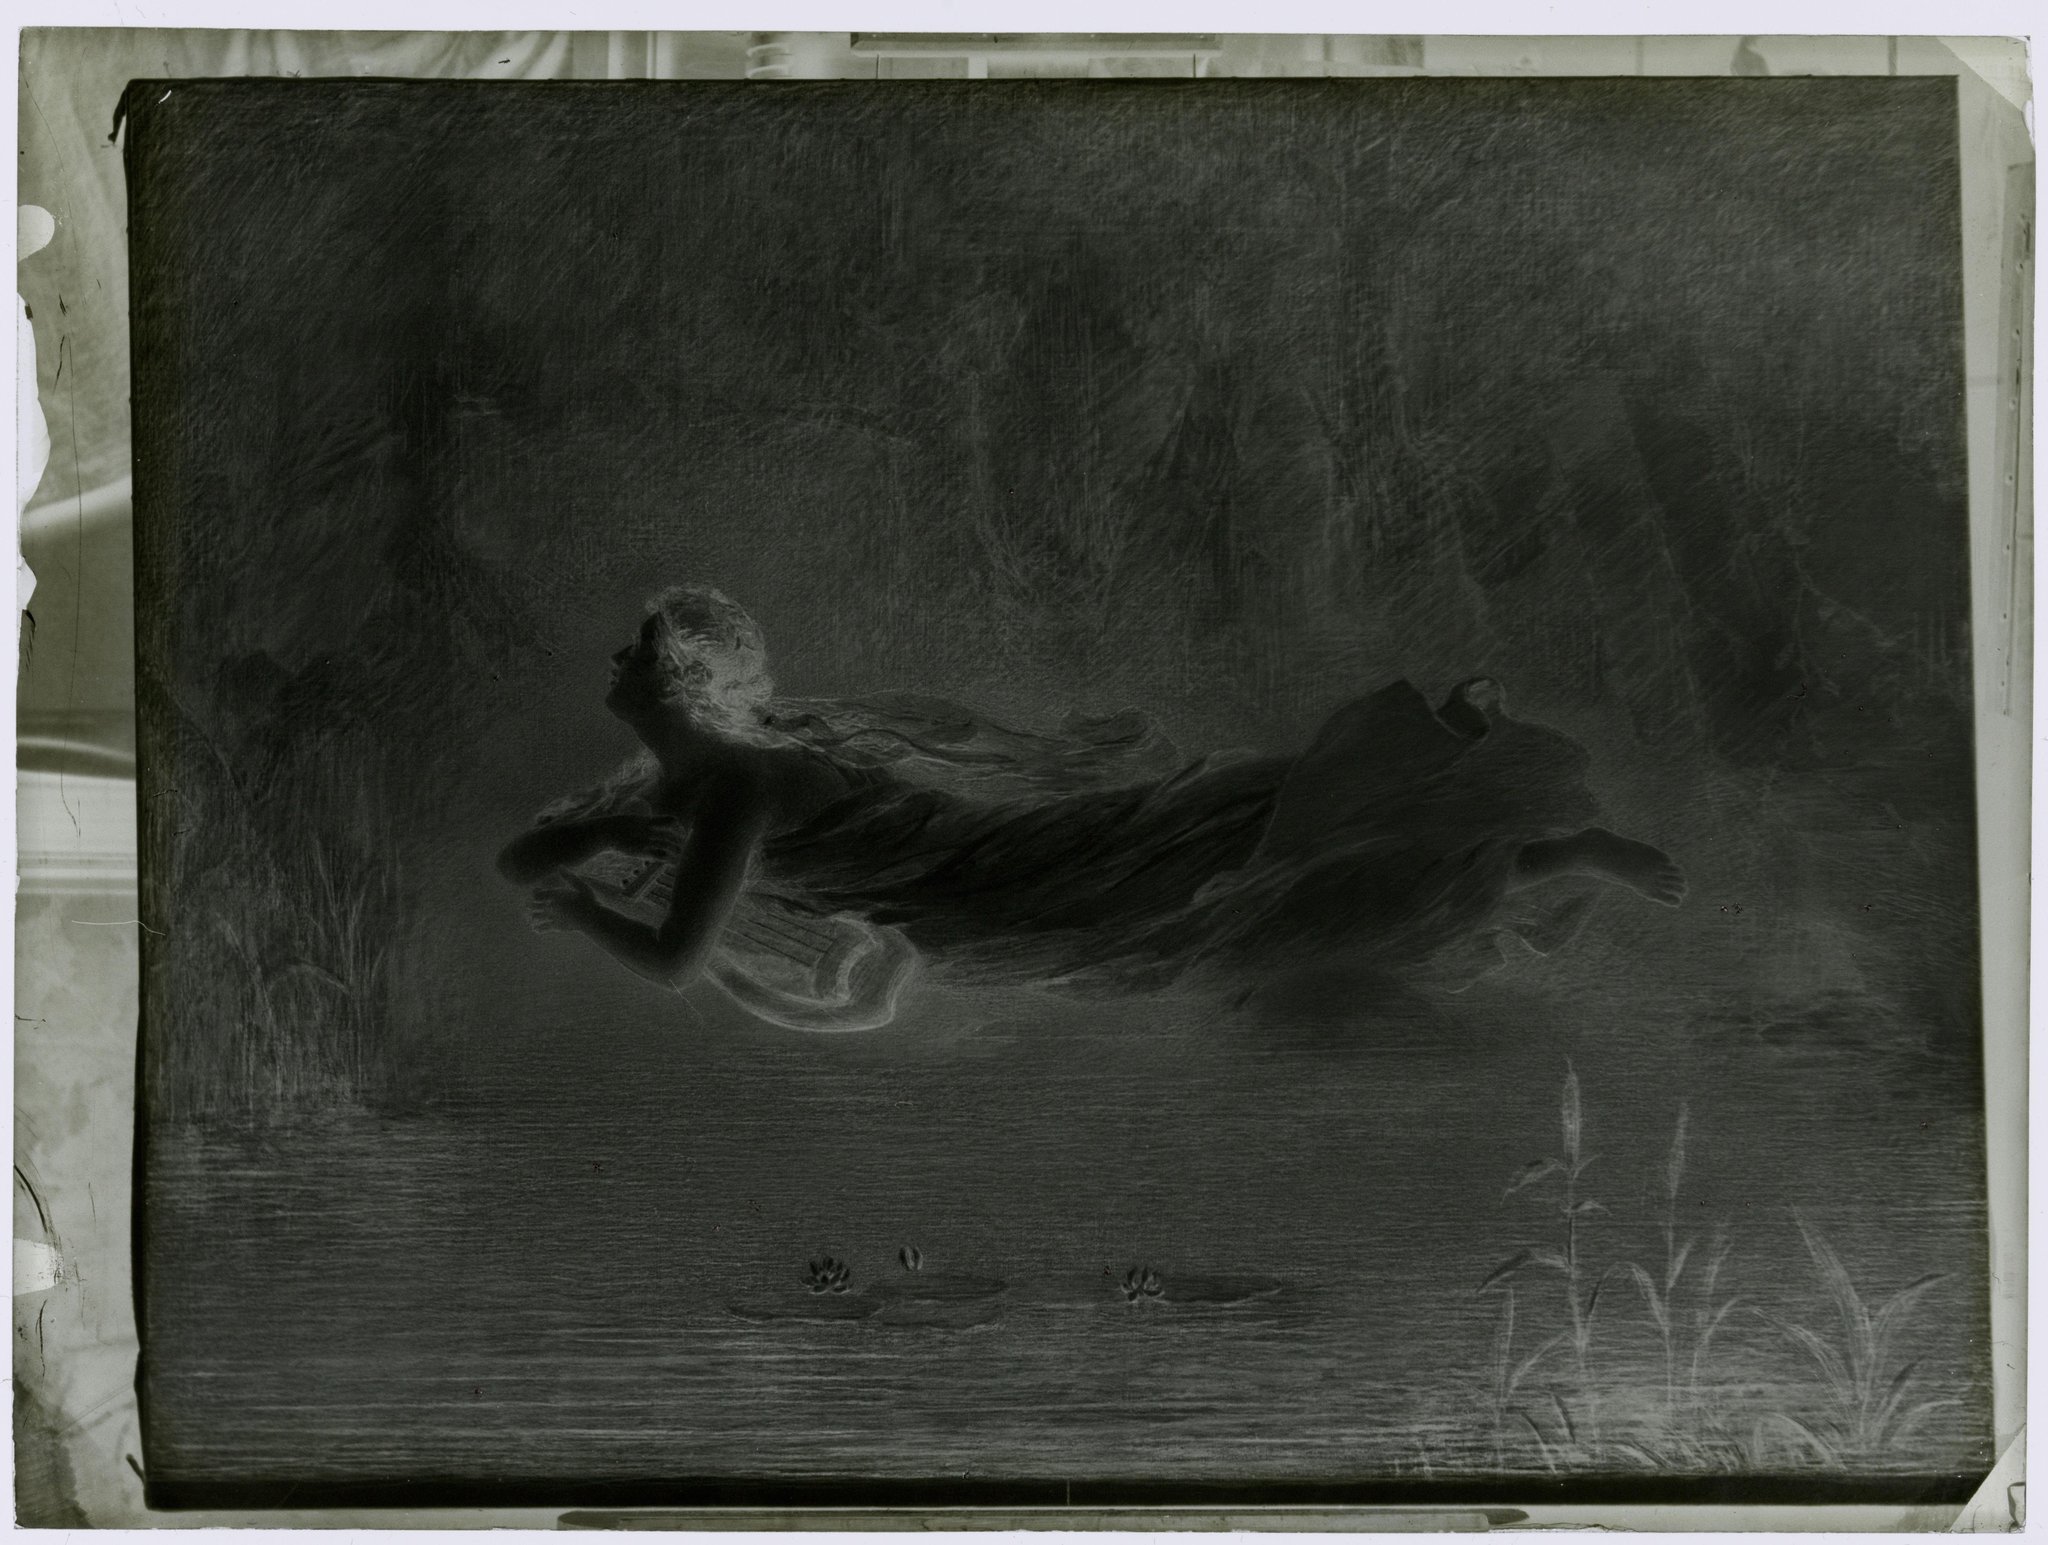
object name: reproduction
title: Fotoreproductie van een schilderij voorstellende een engel met luit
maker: laurens lodewijk kleijn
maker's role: draughtsman, painter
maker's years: 1826-1909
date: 1865-1900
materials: glass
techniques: collodion process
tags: picture, painting, angels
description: Onderdeel van groep glasnegatieven uit de nalatenschap van de schilder Laurens Lodewijk Kleijn, stillevens, portretten, zelfportretten en kunstreproducties.